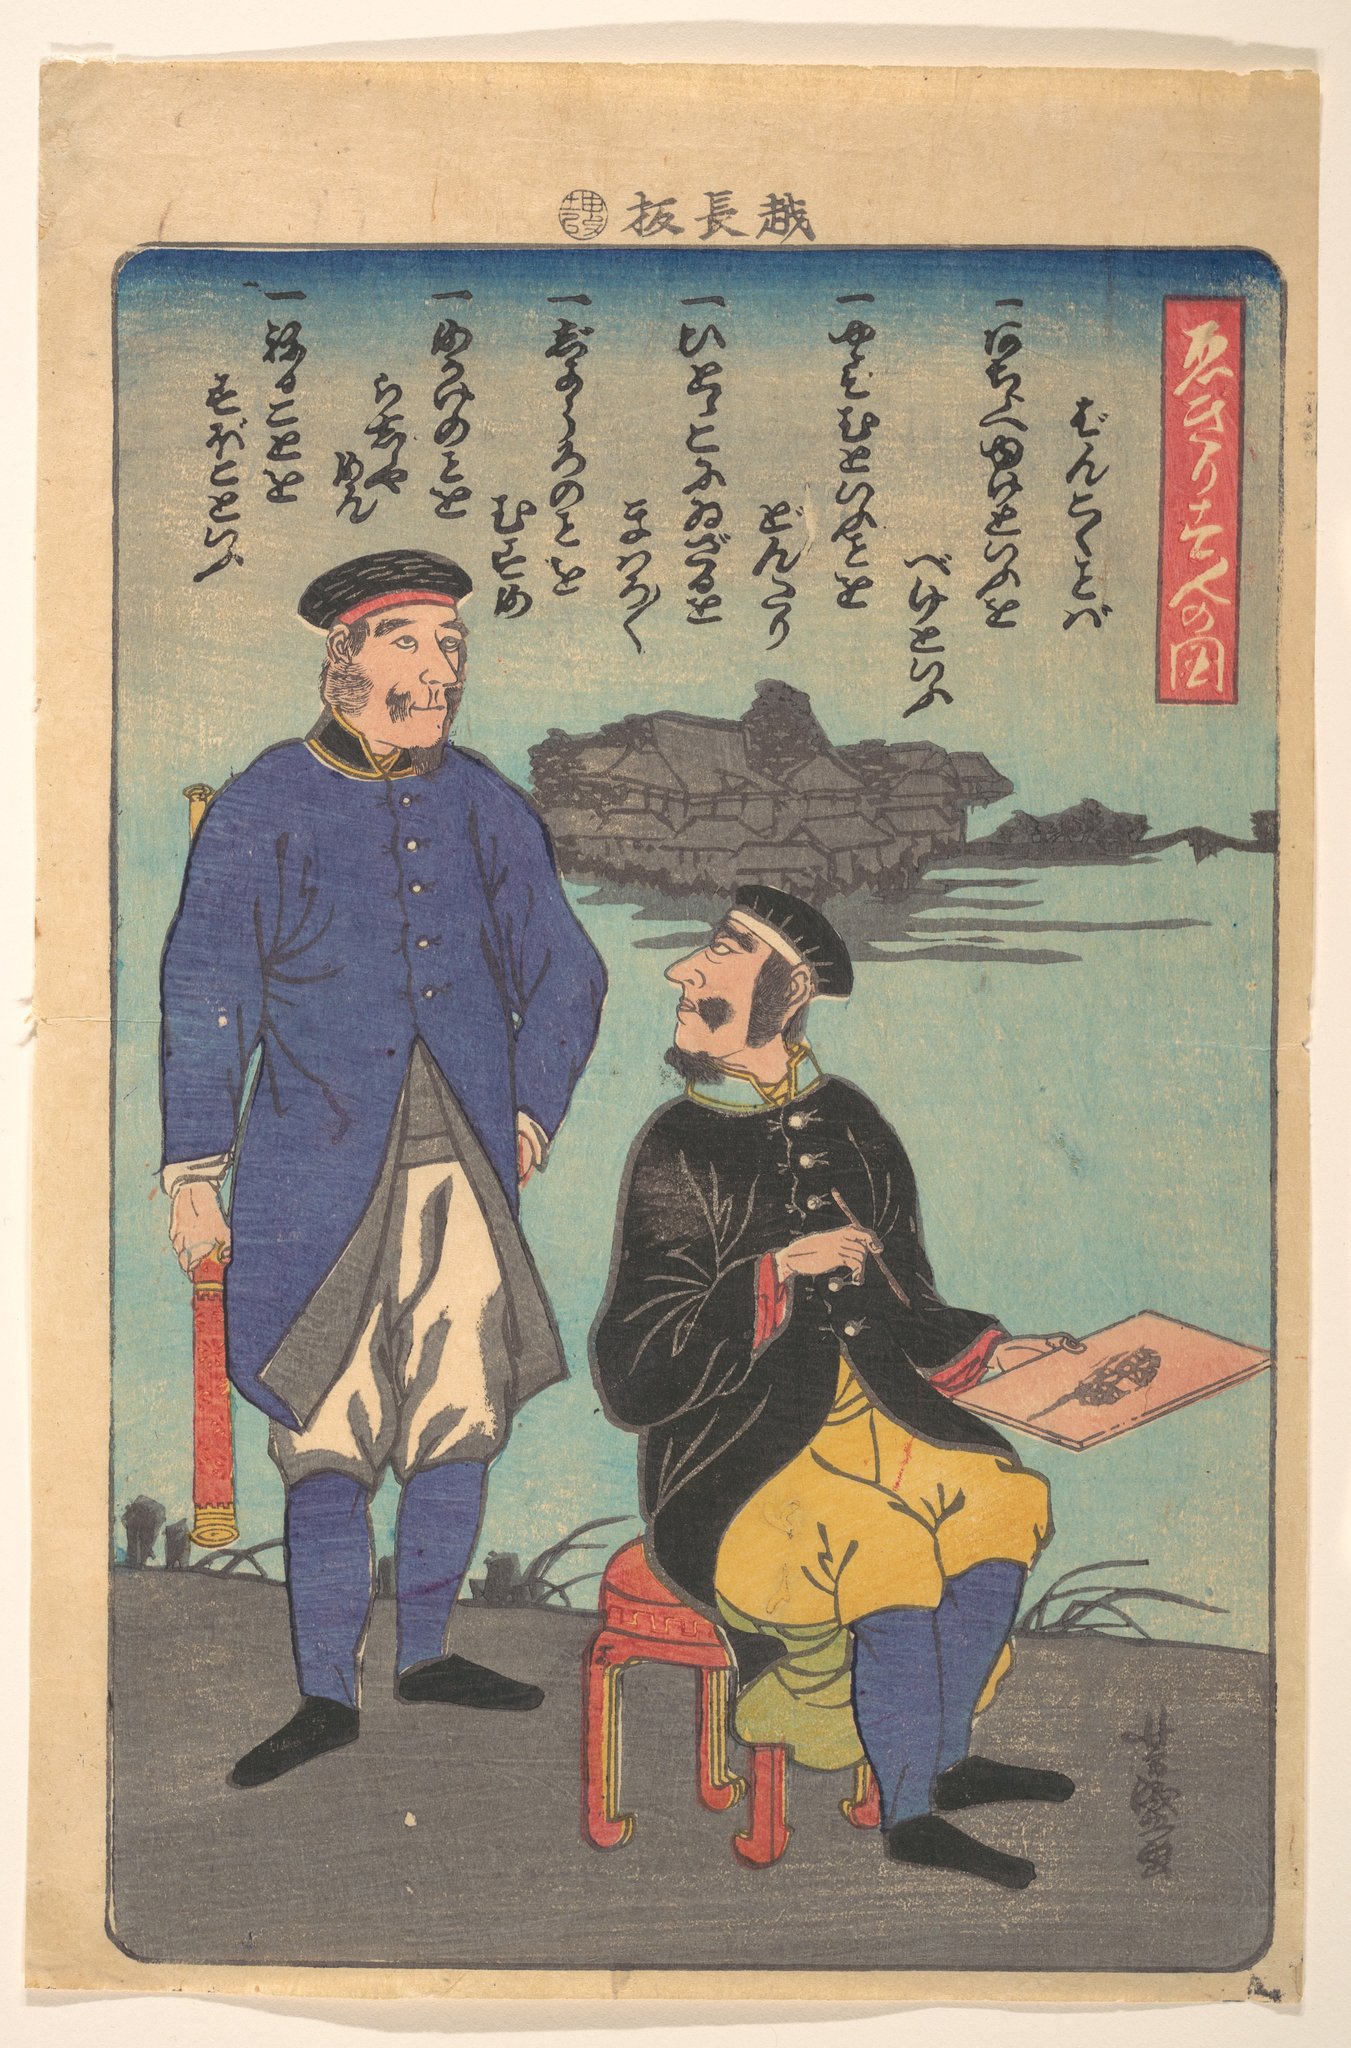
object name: print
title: Englishmen: One Standing, One Sketching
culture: japanese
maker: utagawa yoshimori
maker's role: artist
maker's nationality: japanese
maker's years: 1830-1884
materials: ink, paper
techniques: woodblock print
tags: painting,men